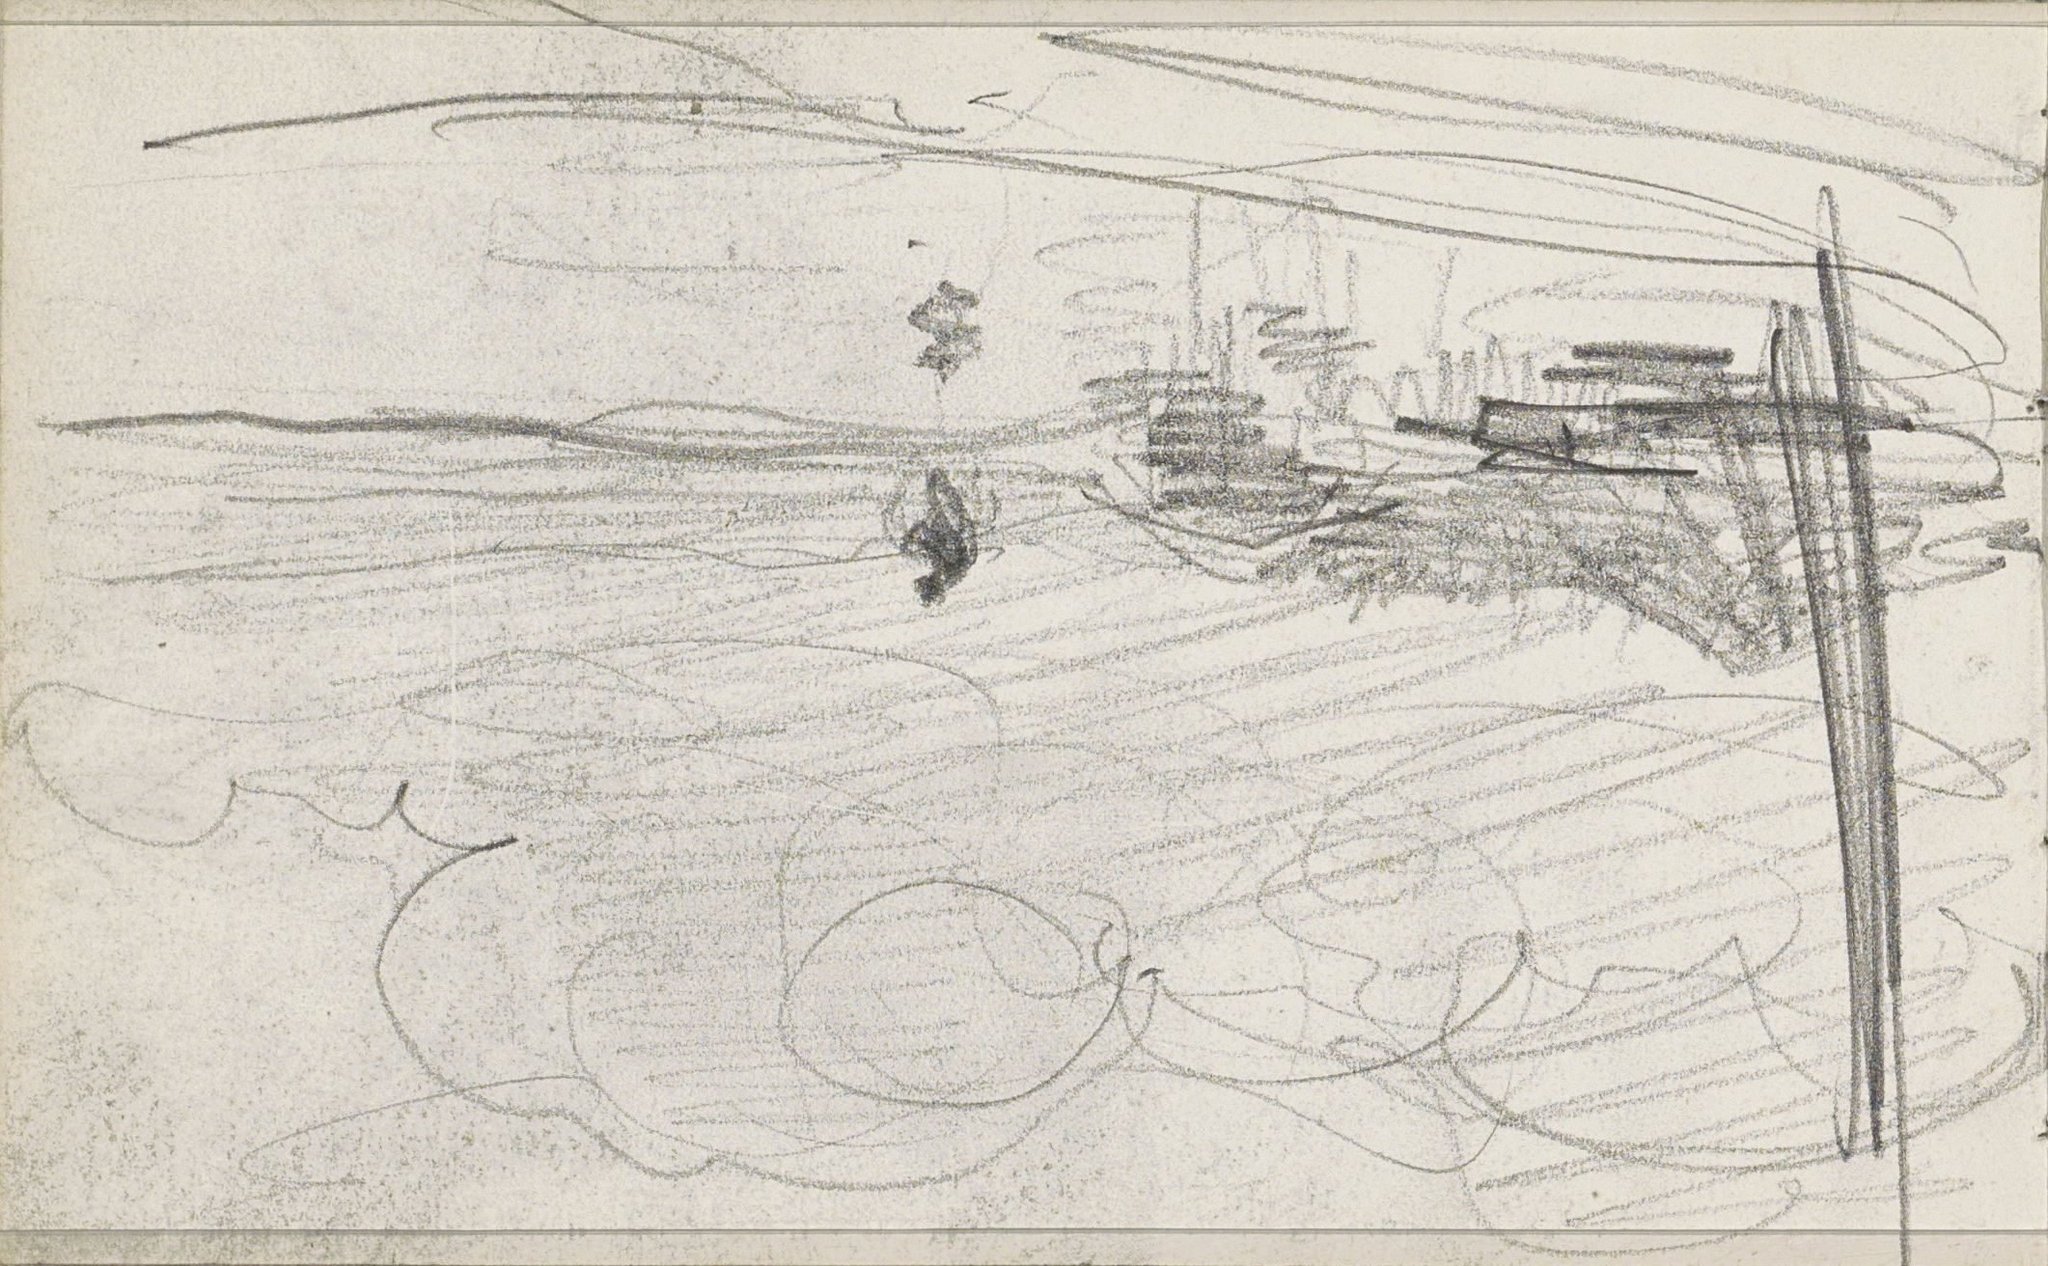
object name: sketchbook leaf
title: Landschap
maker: anton mauve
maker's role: draughtsman, painter, print maker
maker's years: 1838-1888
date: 1848-1888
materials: paper, pencil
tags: landscapes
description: Blad 20 verso uit een schetsboek met 43 bladen.